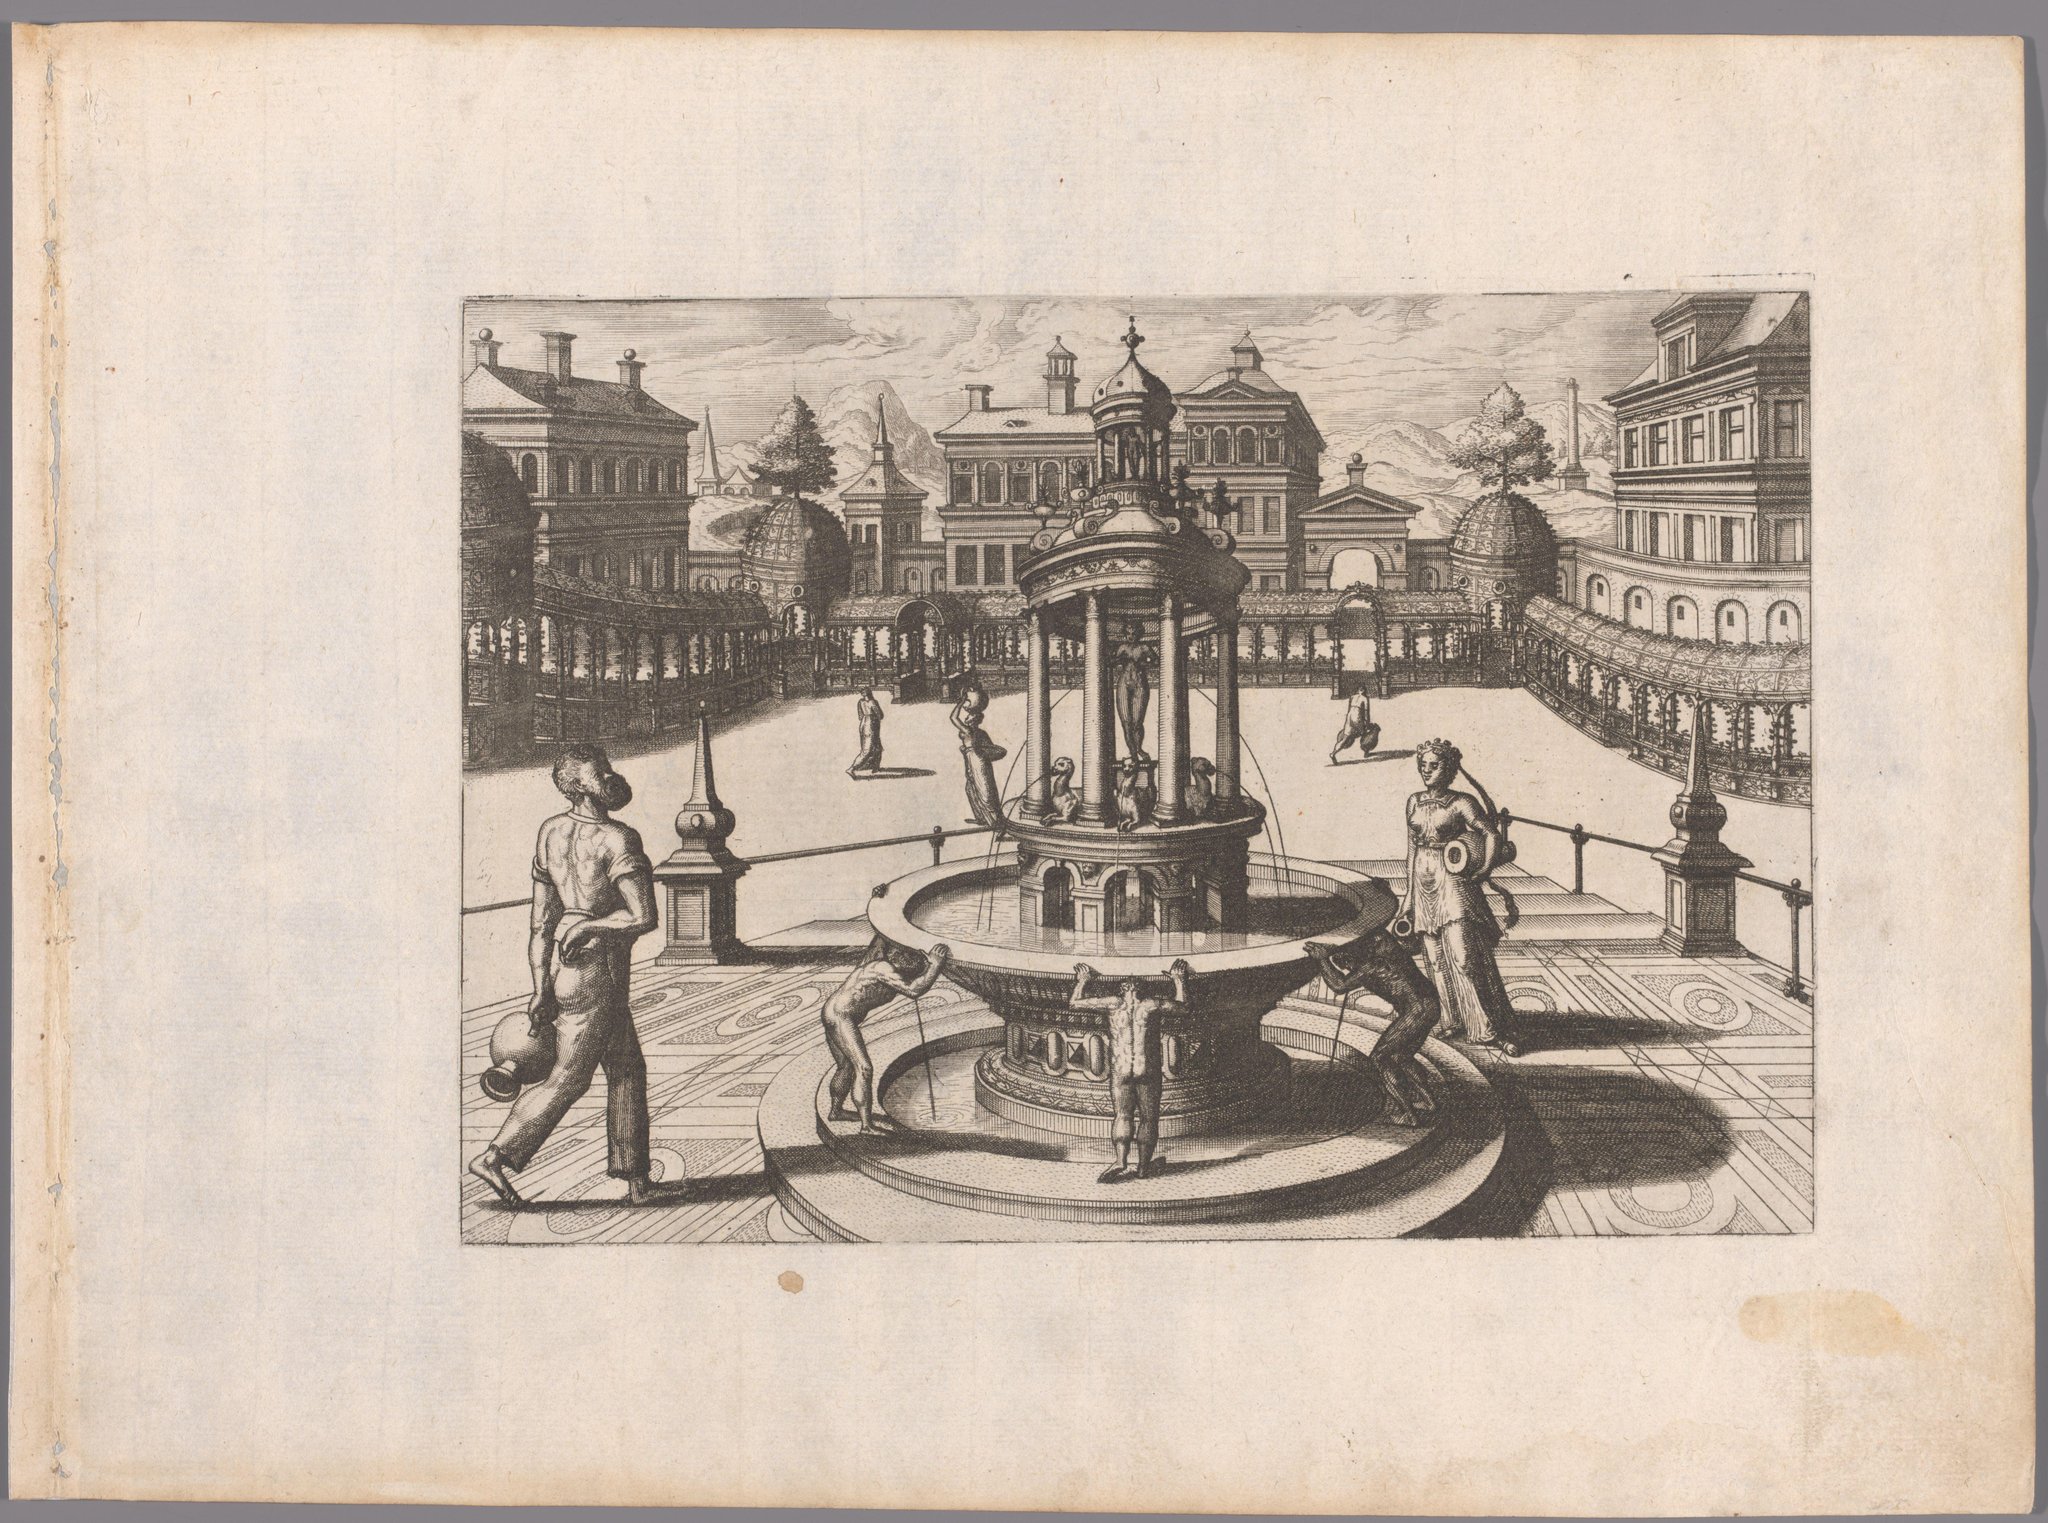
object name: print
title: Fontein bekroond met ronde tempel op plein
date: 1568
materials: paper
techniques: etching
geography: antwerp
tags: piece of sculpture, reproduction of a piece of sculpture, ornamental fountain, village square, place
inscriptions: collector's mark: Lugt 2228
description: Plein met een ronde fontein, bestaande uit een bekken waar drie water spuwende kinderen of mannen tegen aan staan. In het bekken staat een ronde tempel van twee verdiepingen waarin zich een vrouw bevindt met drie leeuwen onder haar voeten. Rond de fontein mannen en vrouwen met kruiken. Rond het plein een gang van traliewerk.